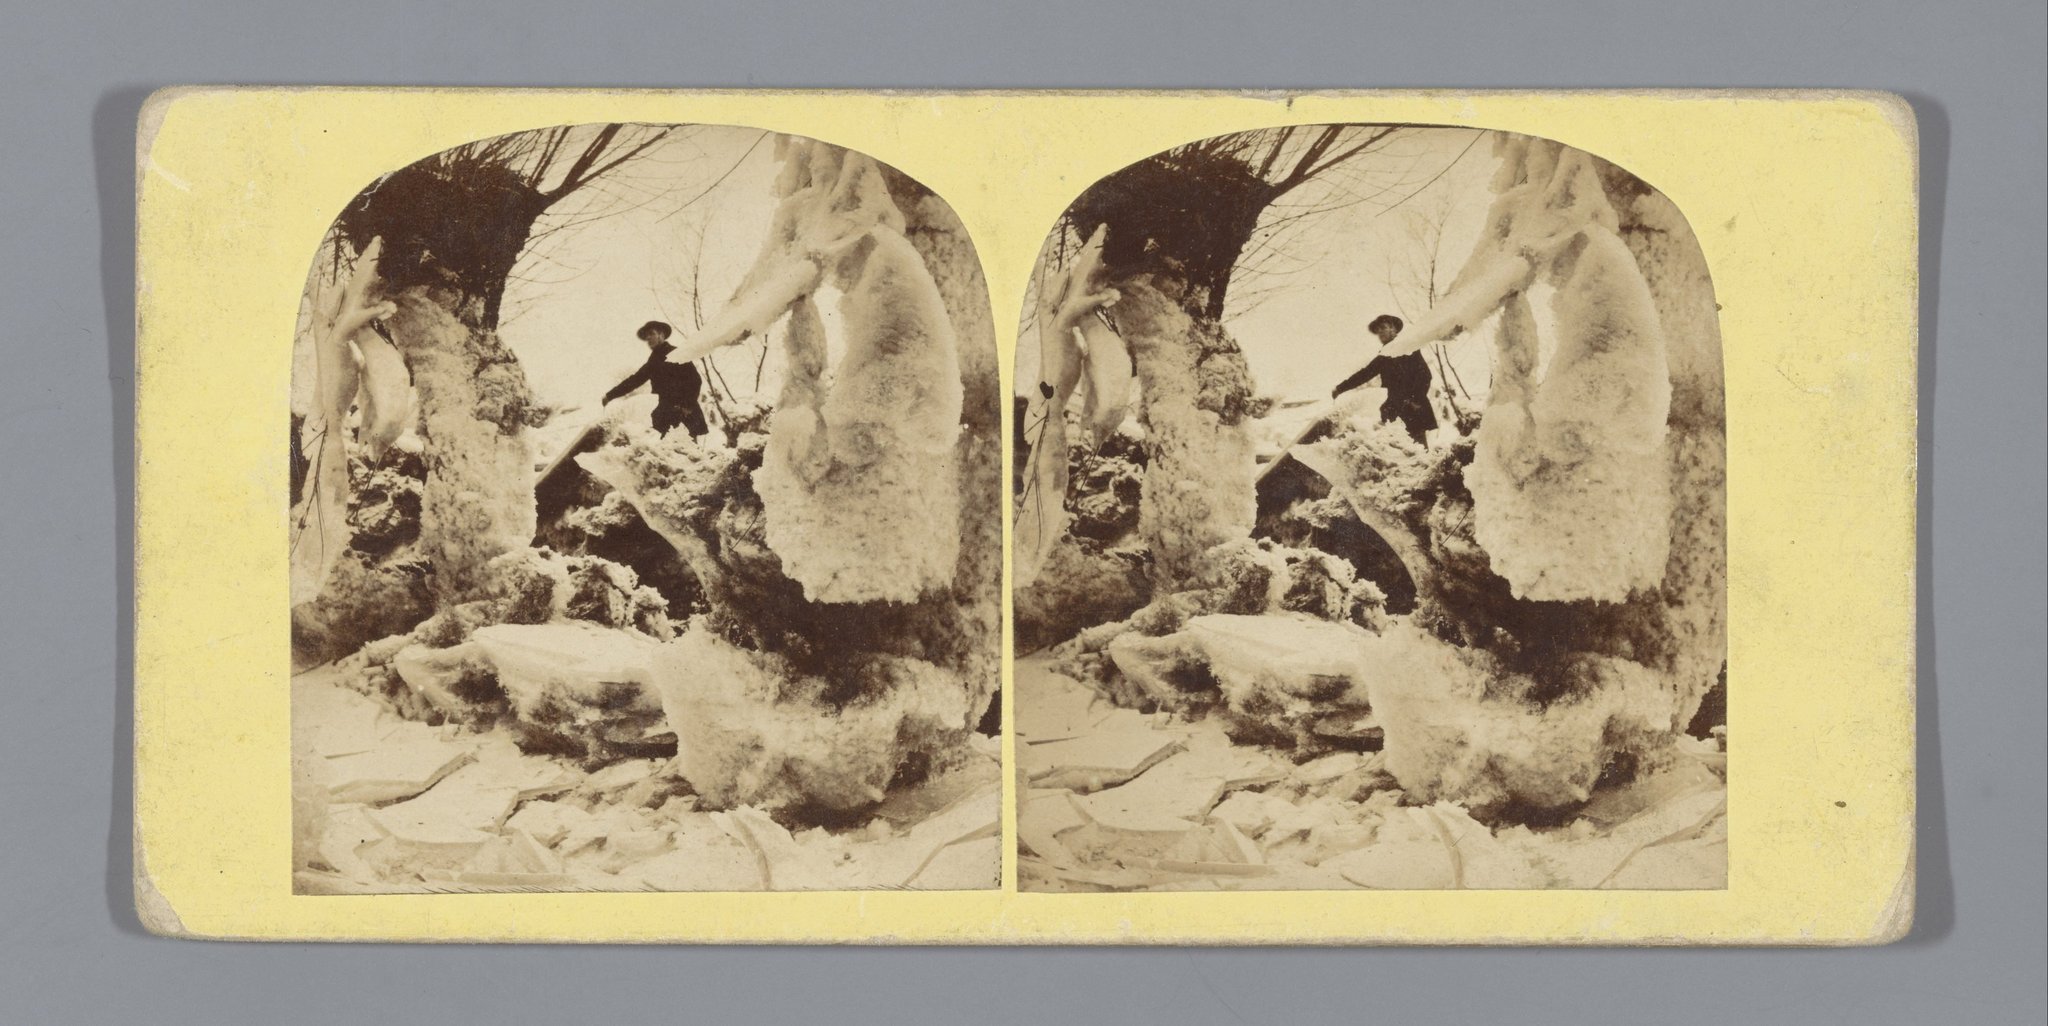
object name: stereograph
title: Winter scene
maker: Anonymous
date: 1850-1880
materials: cardboard, photographic support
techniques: albumen print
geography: europe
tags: drift ice, europe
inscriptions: number: ‘47.’